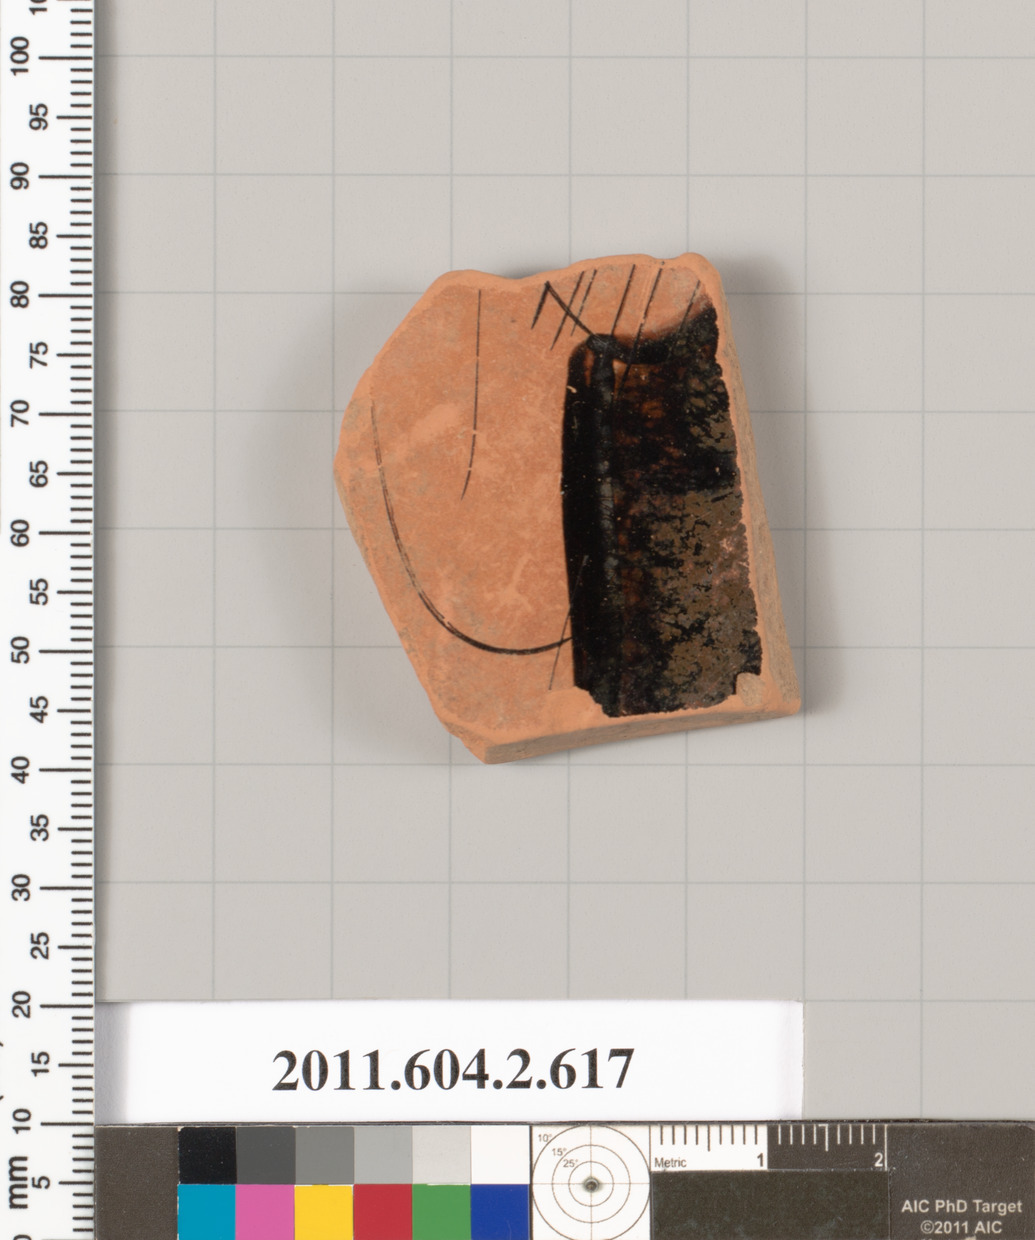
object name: column krater fragment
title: Terracotta fragment of a column-krater (bowl for mixing wine and water)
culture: greek, attic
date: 460-440 BCE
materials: terracotta